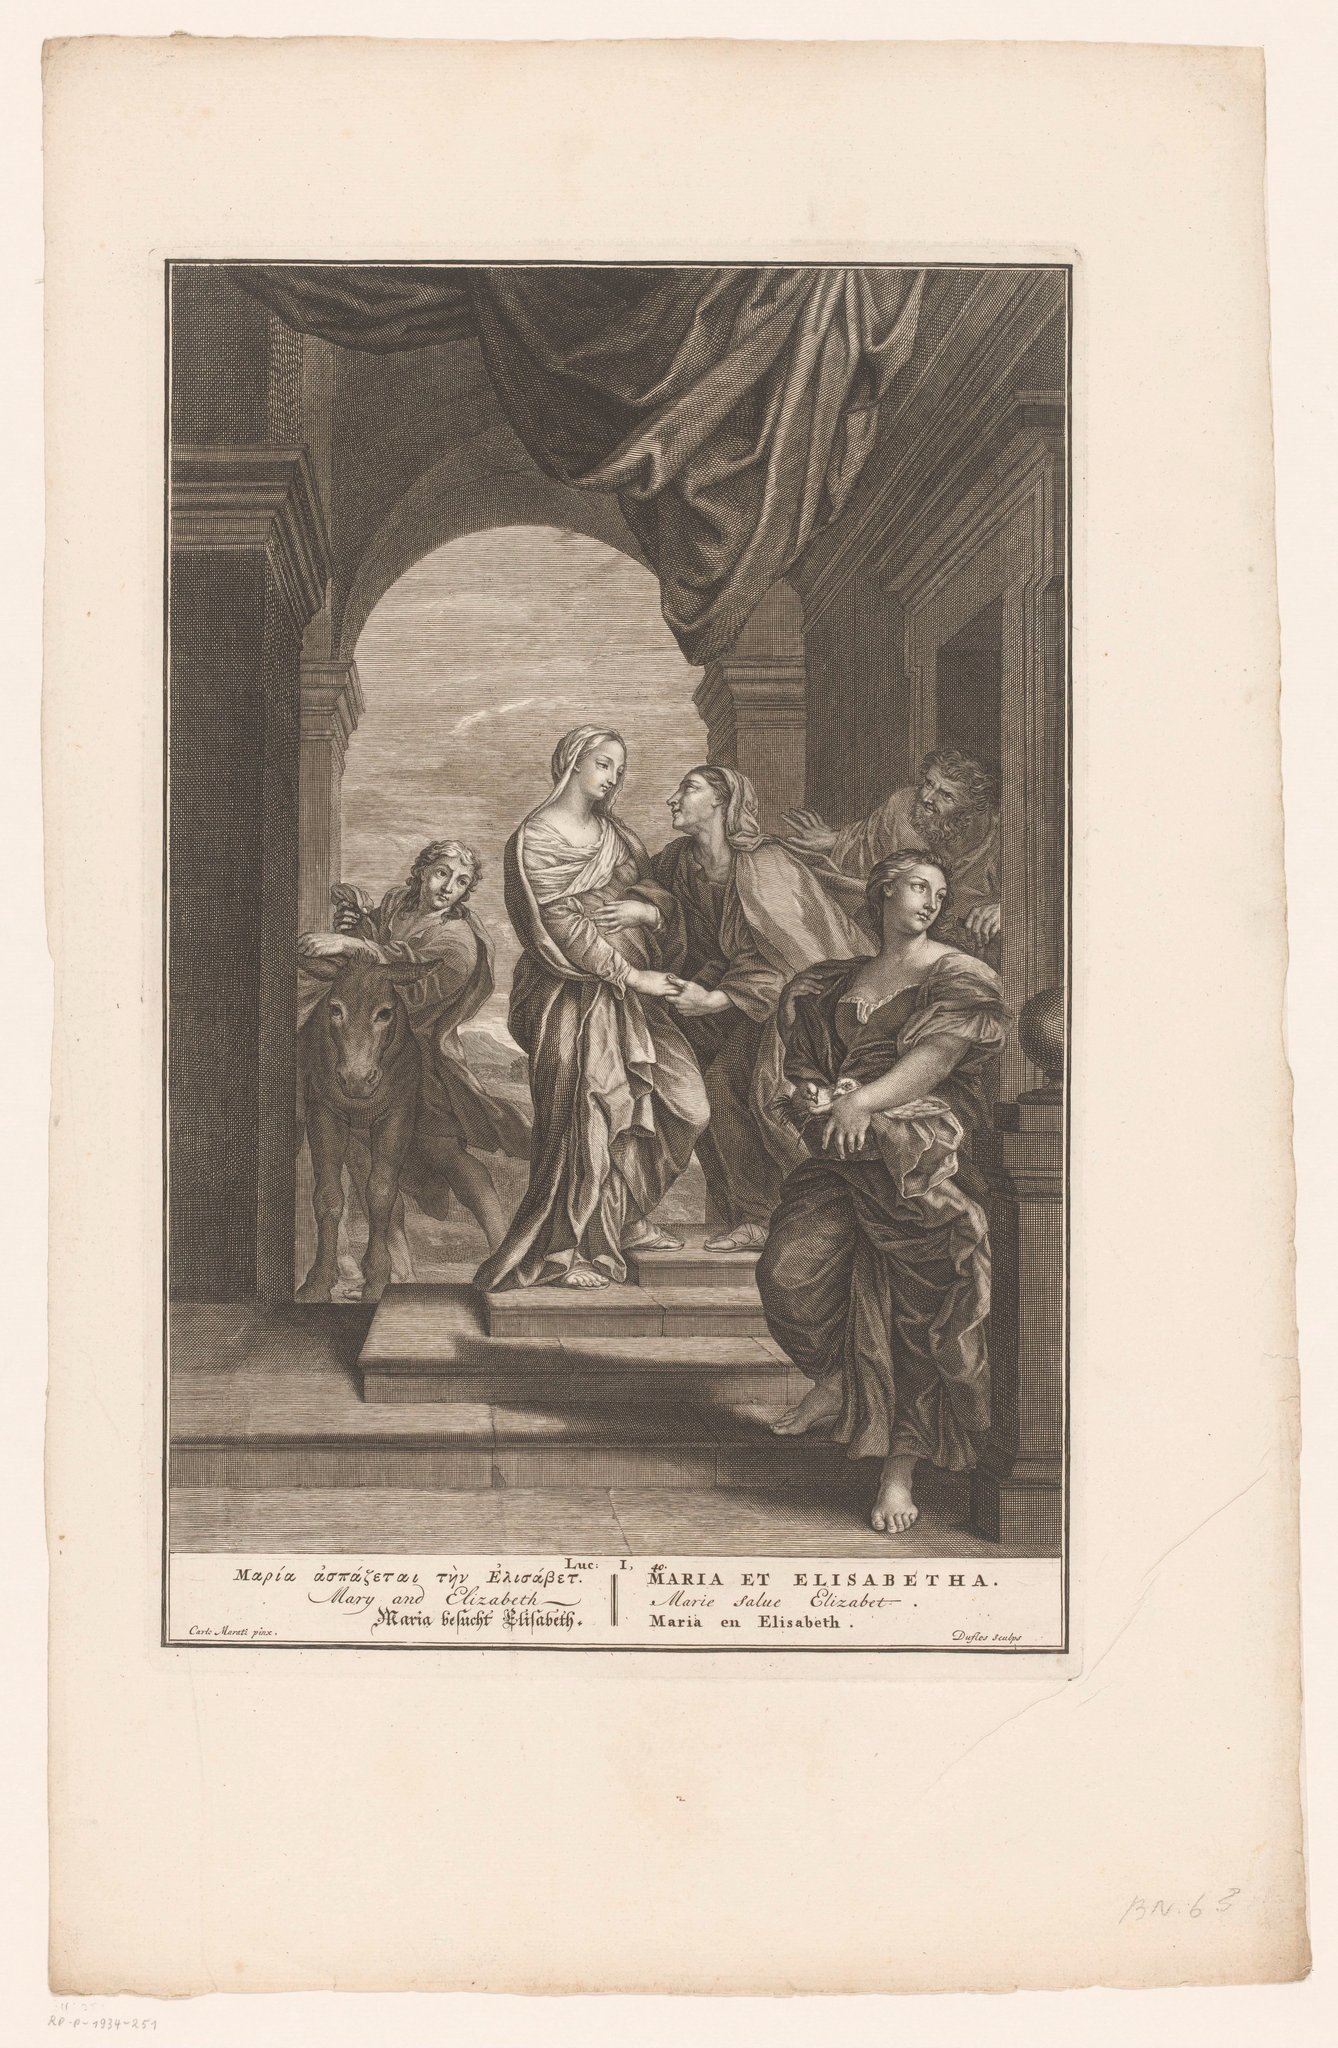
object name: print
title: Visitatie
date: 1675-1727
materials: paper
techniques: engraving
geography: france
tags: other birds: dove, ass, donkey, mary's stay in the house of elisabeth ~ visitation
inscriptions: collector's mark: Lugt 2228, inscription: ‘Ûtrechts [...]indatie huijs’